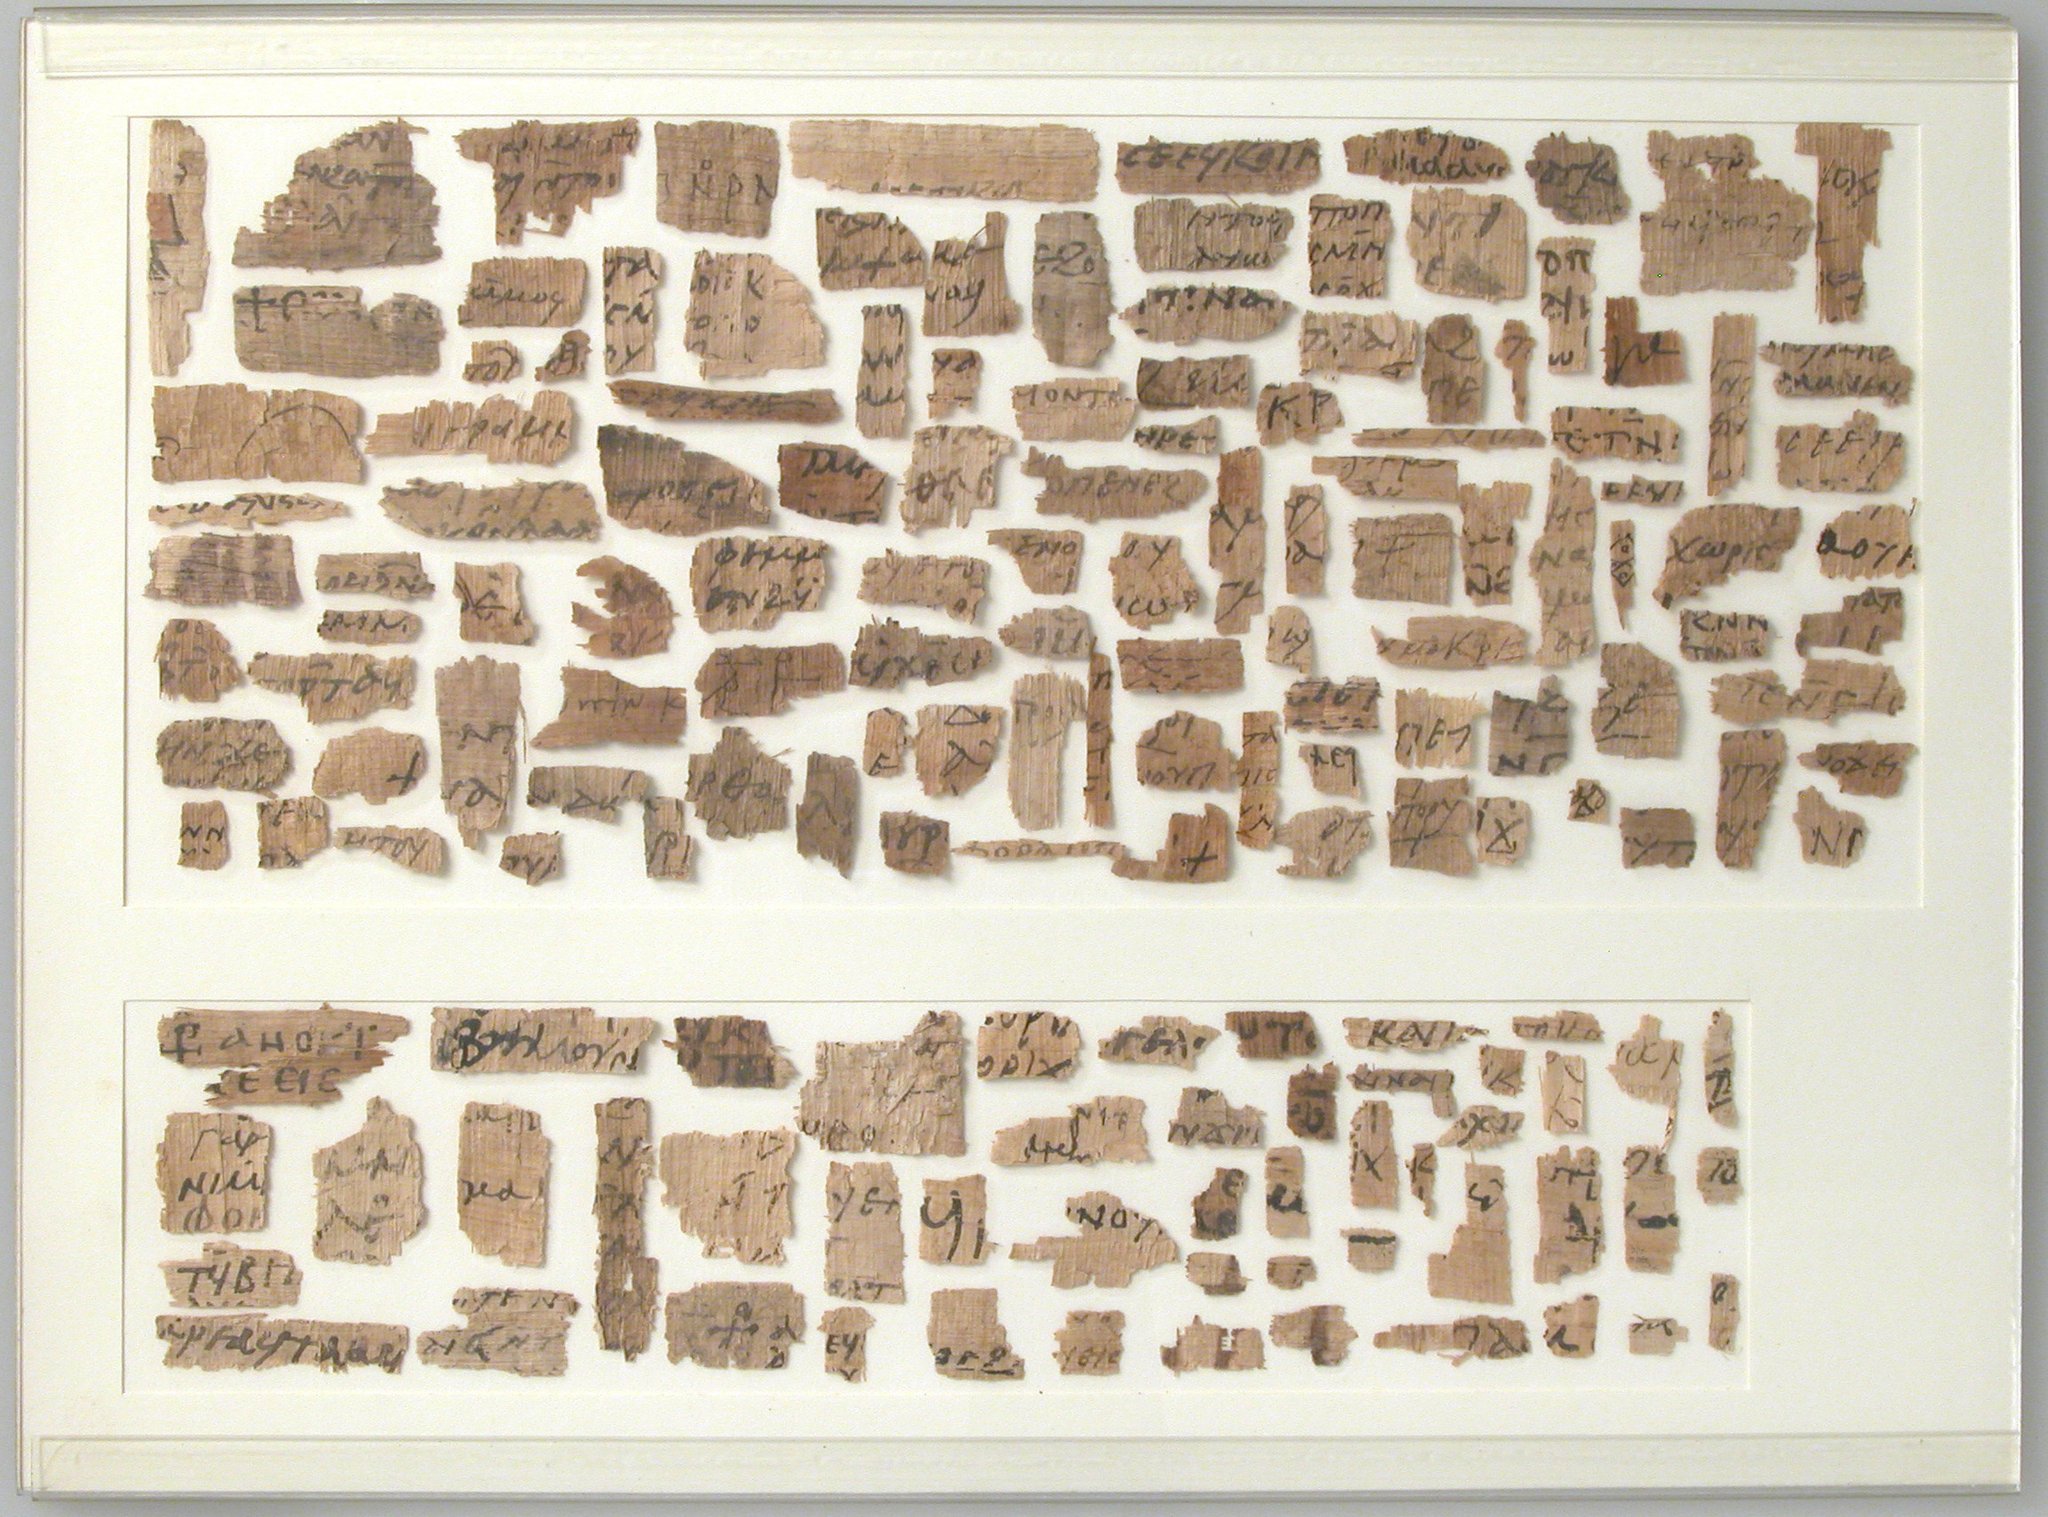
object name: fragment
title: Papyri Fragments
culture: coptic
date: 601-700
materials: ink, papyrus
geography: egypt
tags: documents